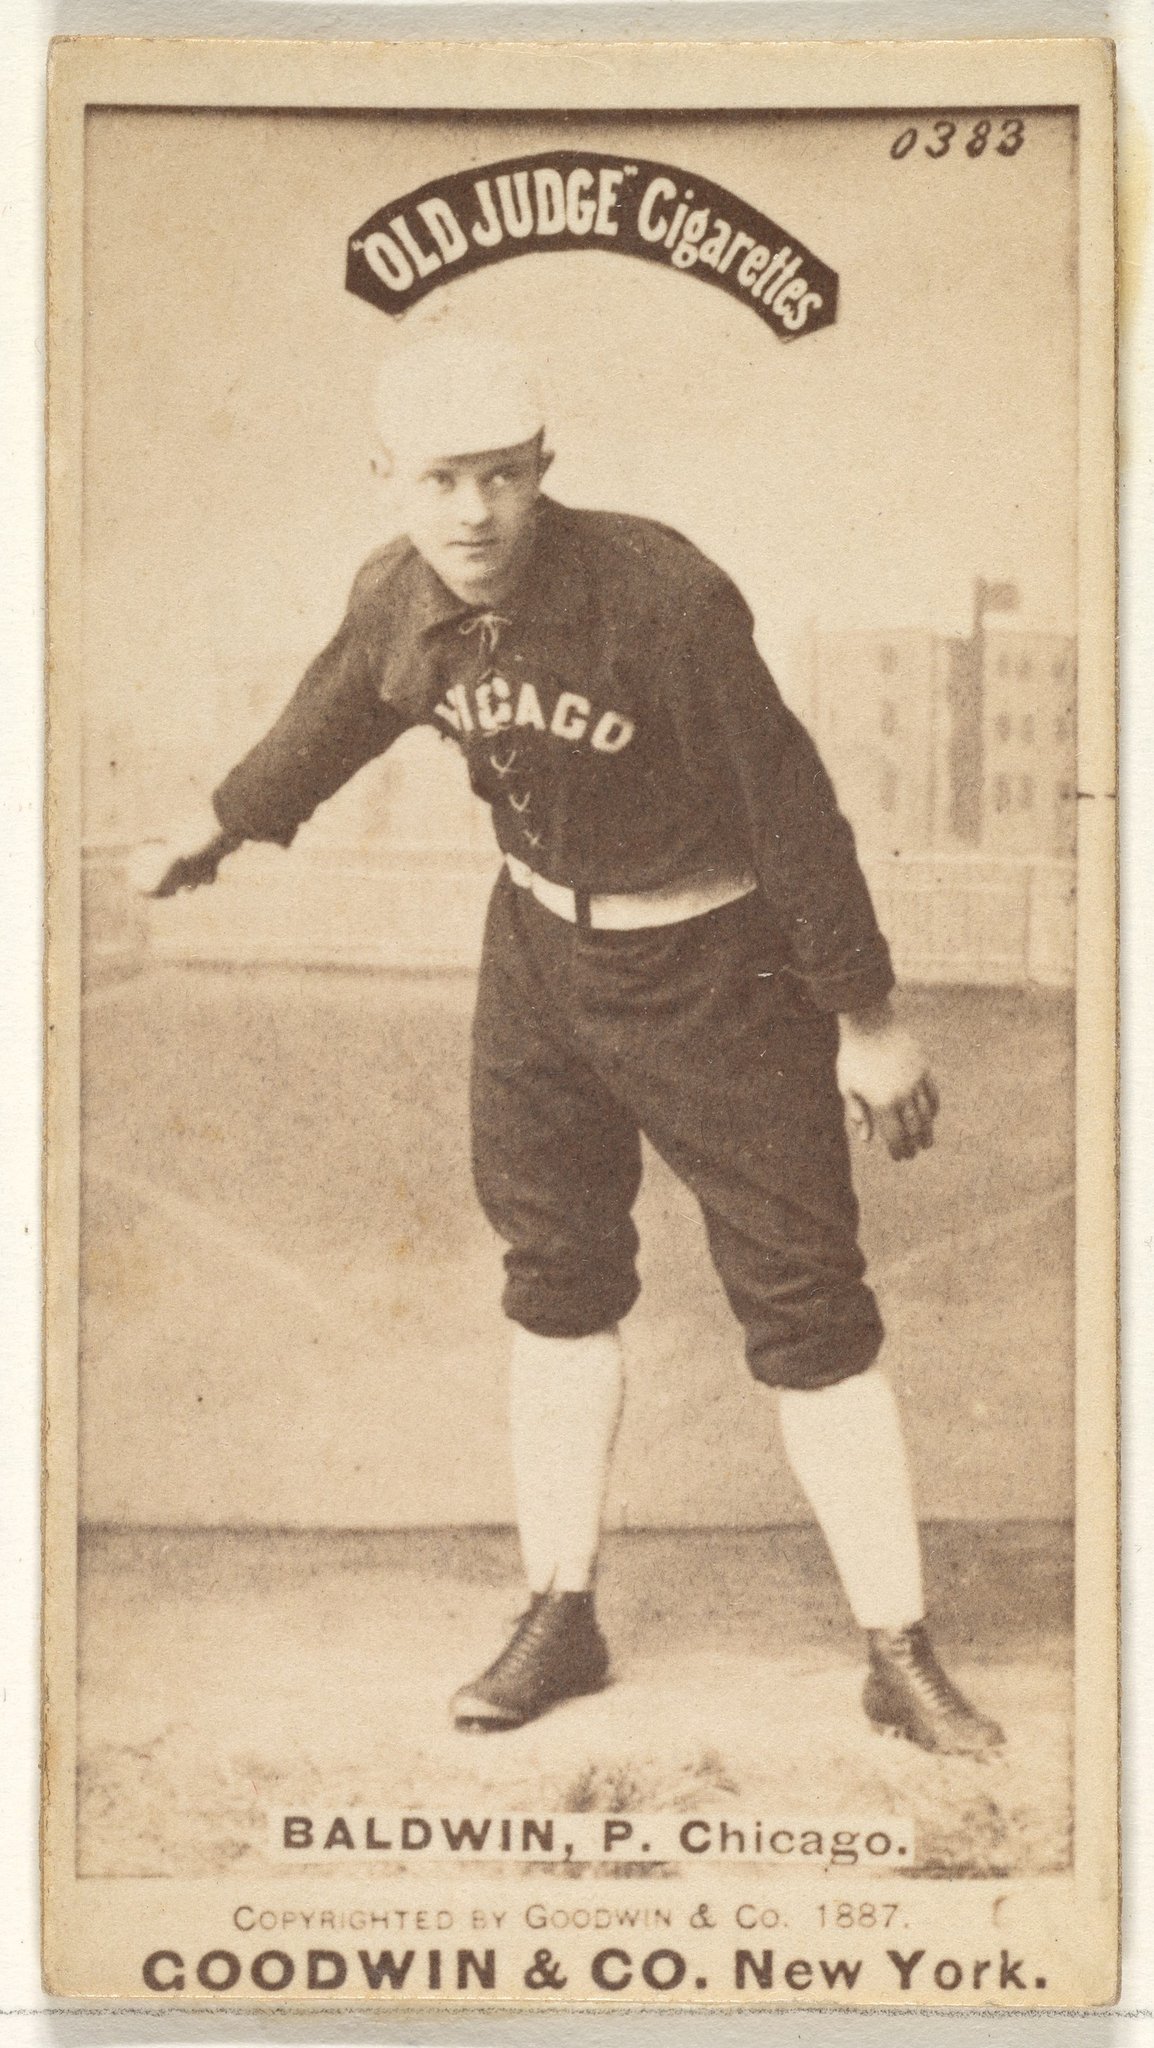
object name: baseball card, photograph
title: Baldwin, Pitcher, Chicago, from the Old Judge series (N172) for Old Judge Cigarettes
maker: goodwin & company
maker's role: publisher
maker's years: 1850-1950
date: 1887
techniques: albumen silver print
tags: men,portraits,baseball,athletes